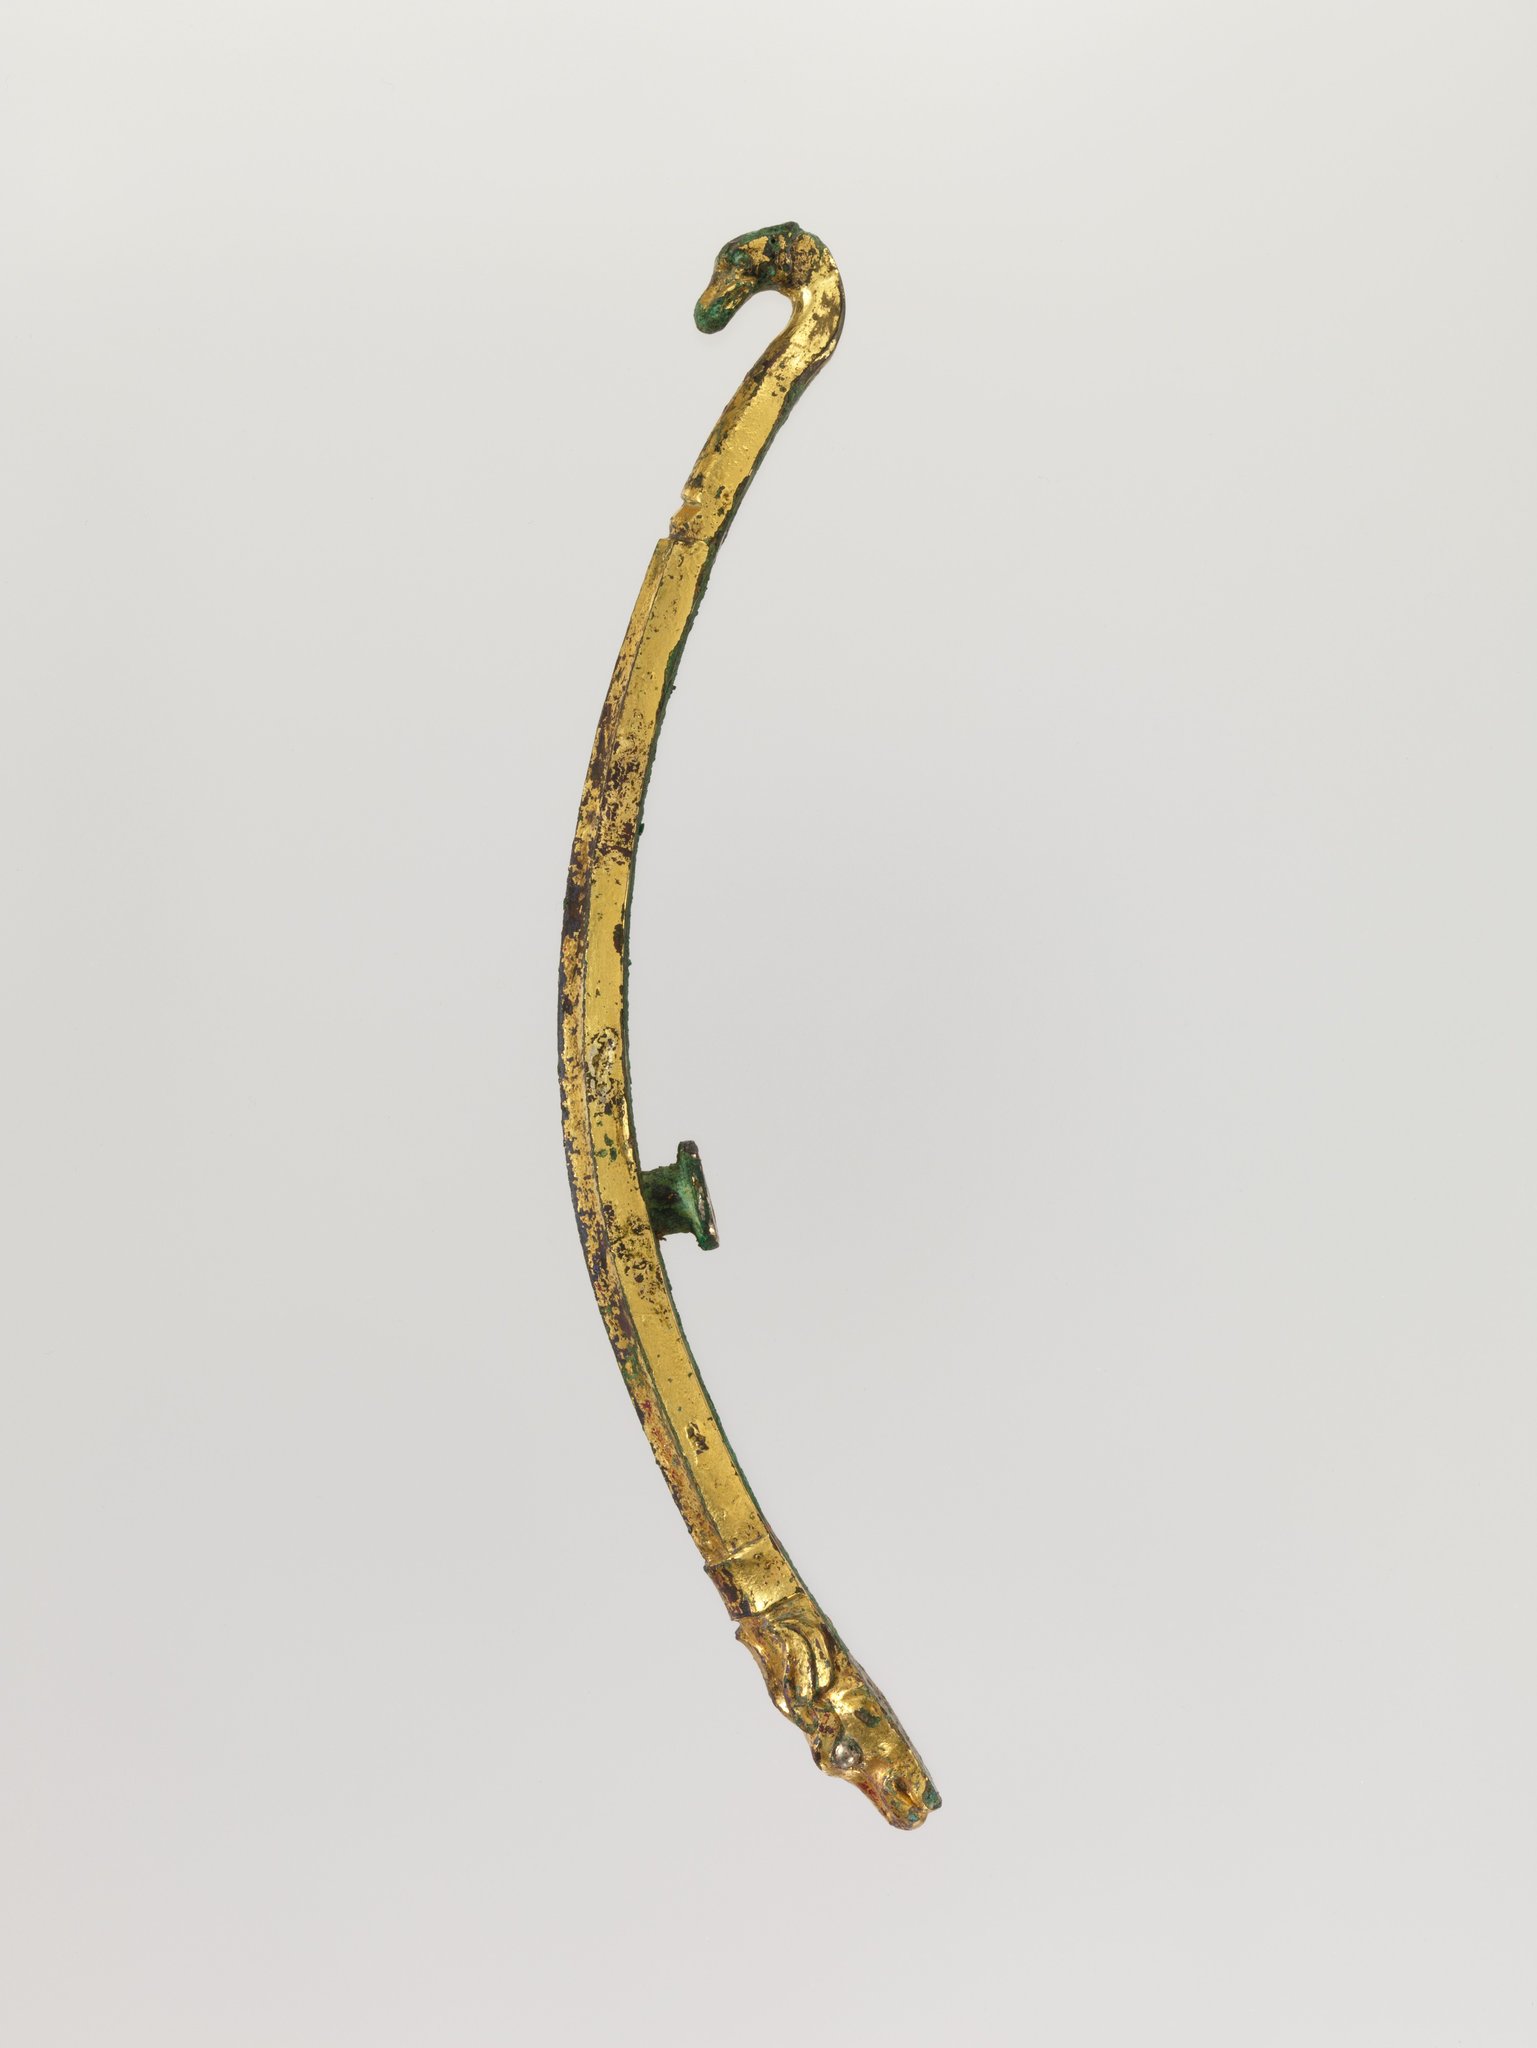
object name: buckle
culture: chinese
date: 206 BCE-220 CE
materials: bronze, gold, silver